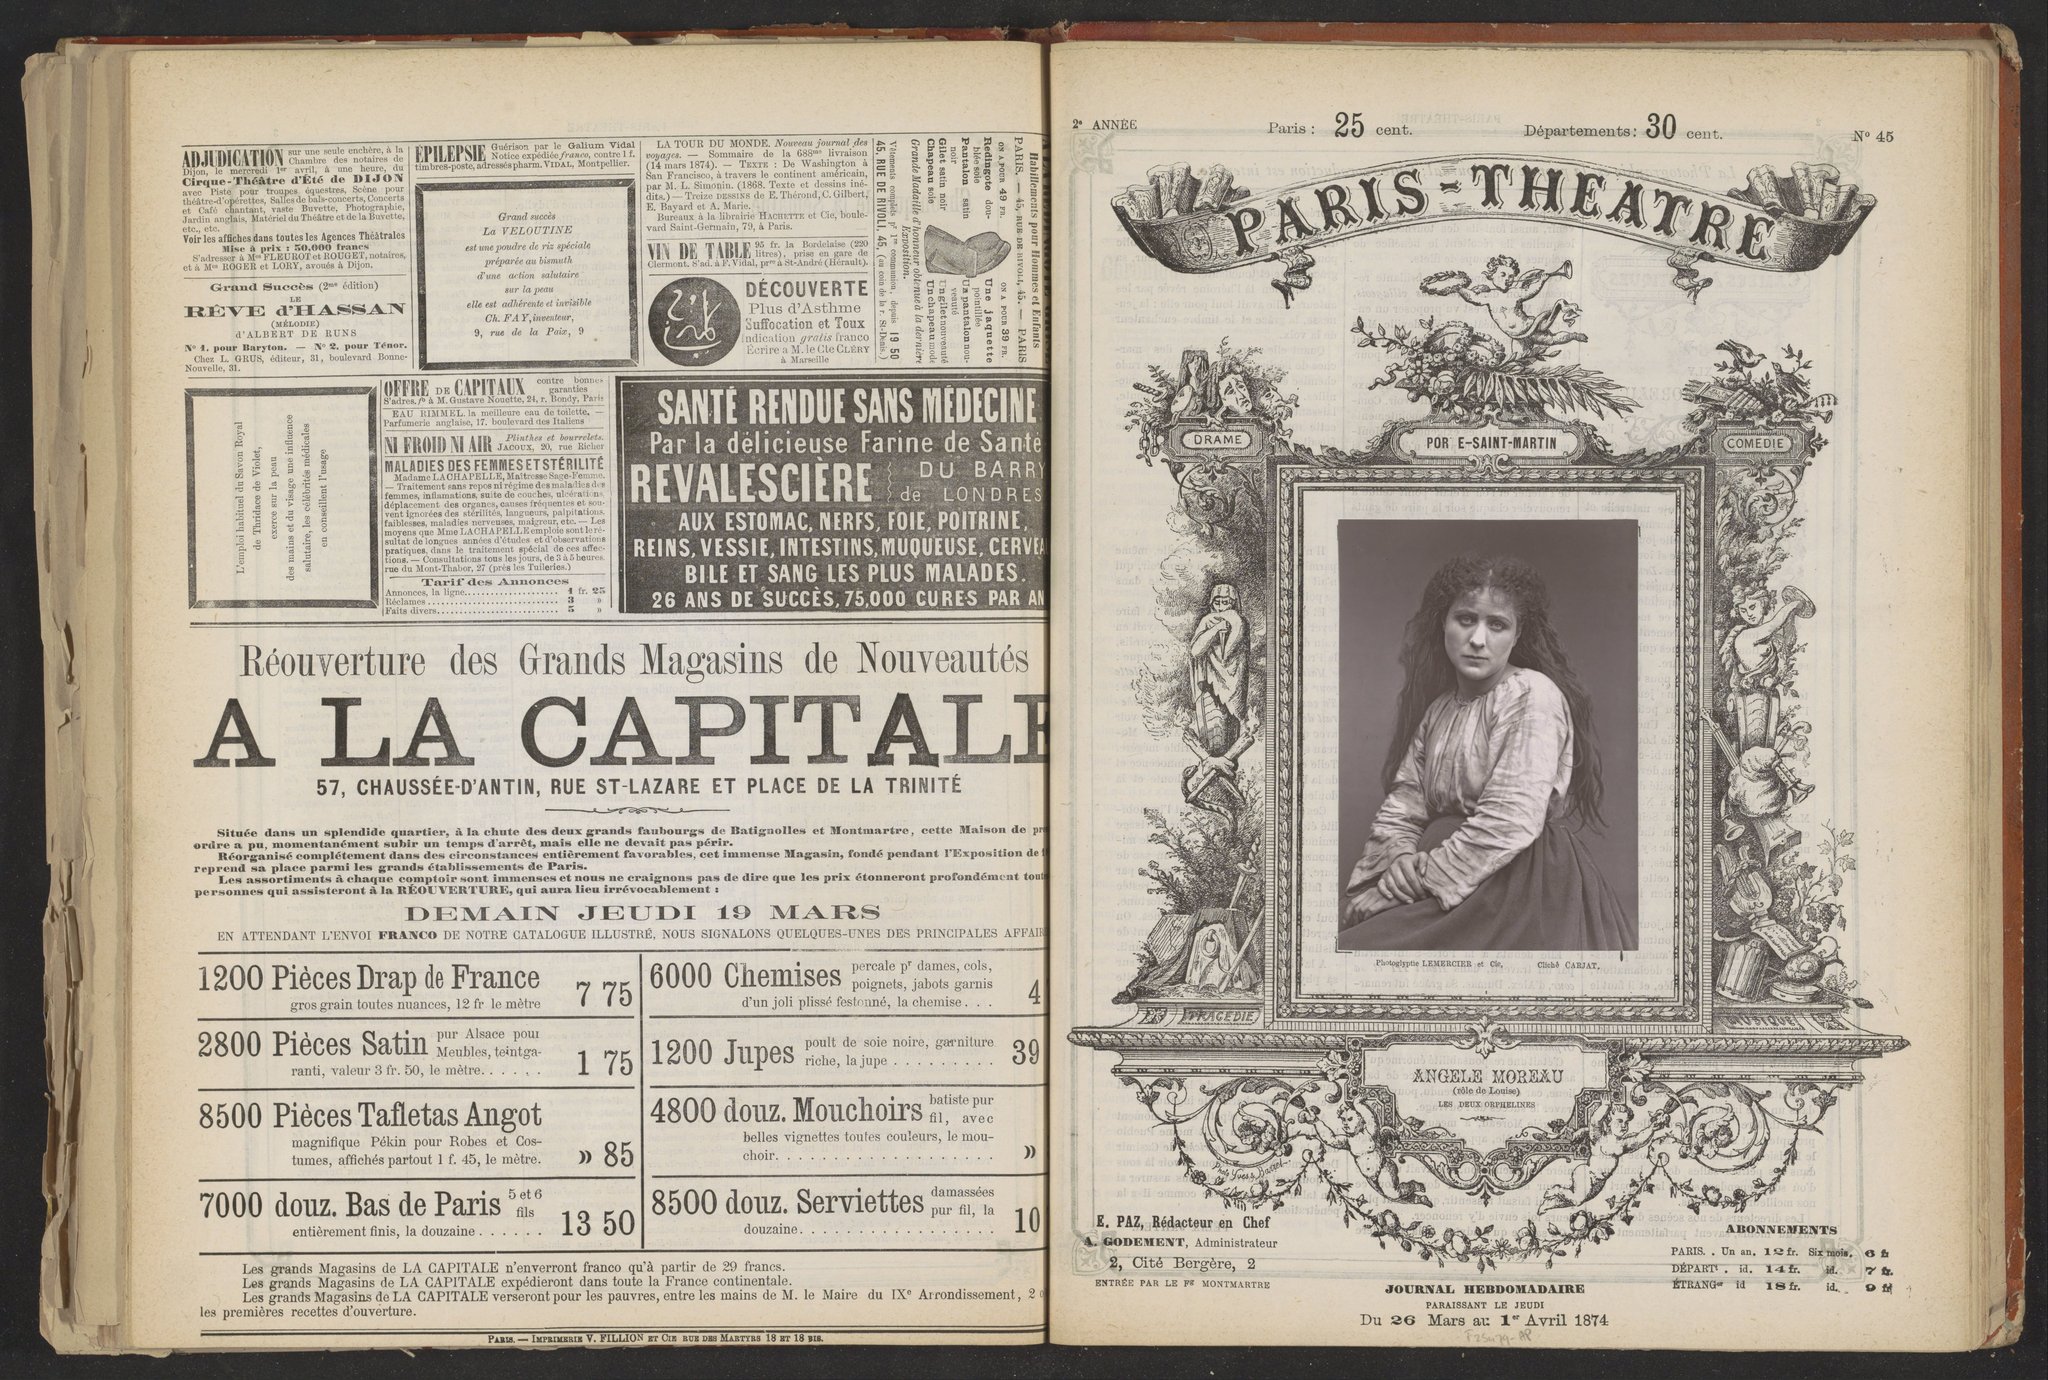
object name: page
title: Angele Moreau (role de Louise) les deux Orphelines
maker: étienne carjat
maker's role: draughtsman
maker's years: 1828-1906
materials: paper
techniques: woodburytype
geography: france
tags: portrait of actor, actress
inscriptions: number: ‘No 45’, inscription: ‘Journal hebdomadaire paraissant le Jeudi Du 26 Mars au 1er Avril 1874’